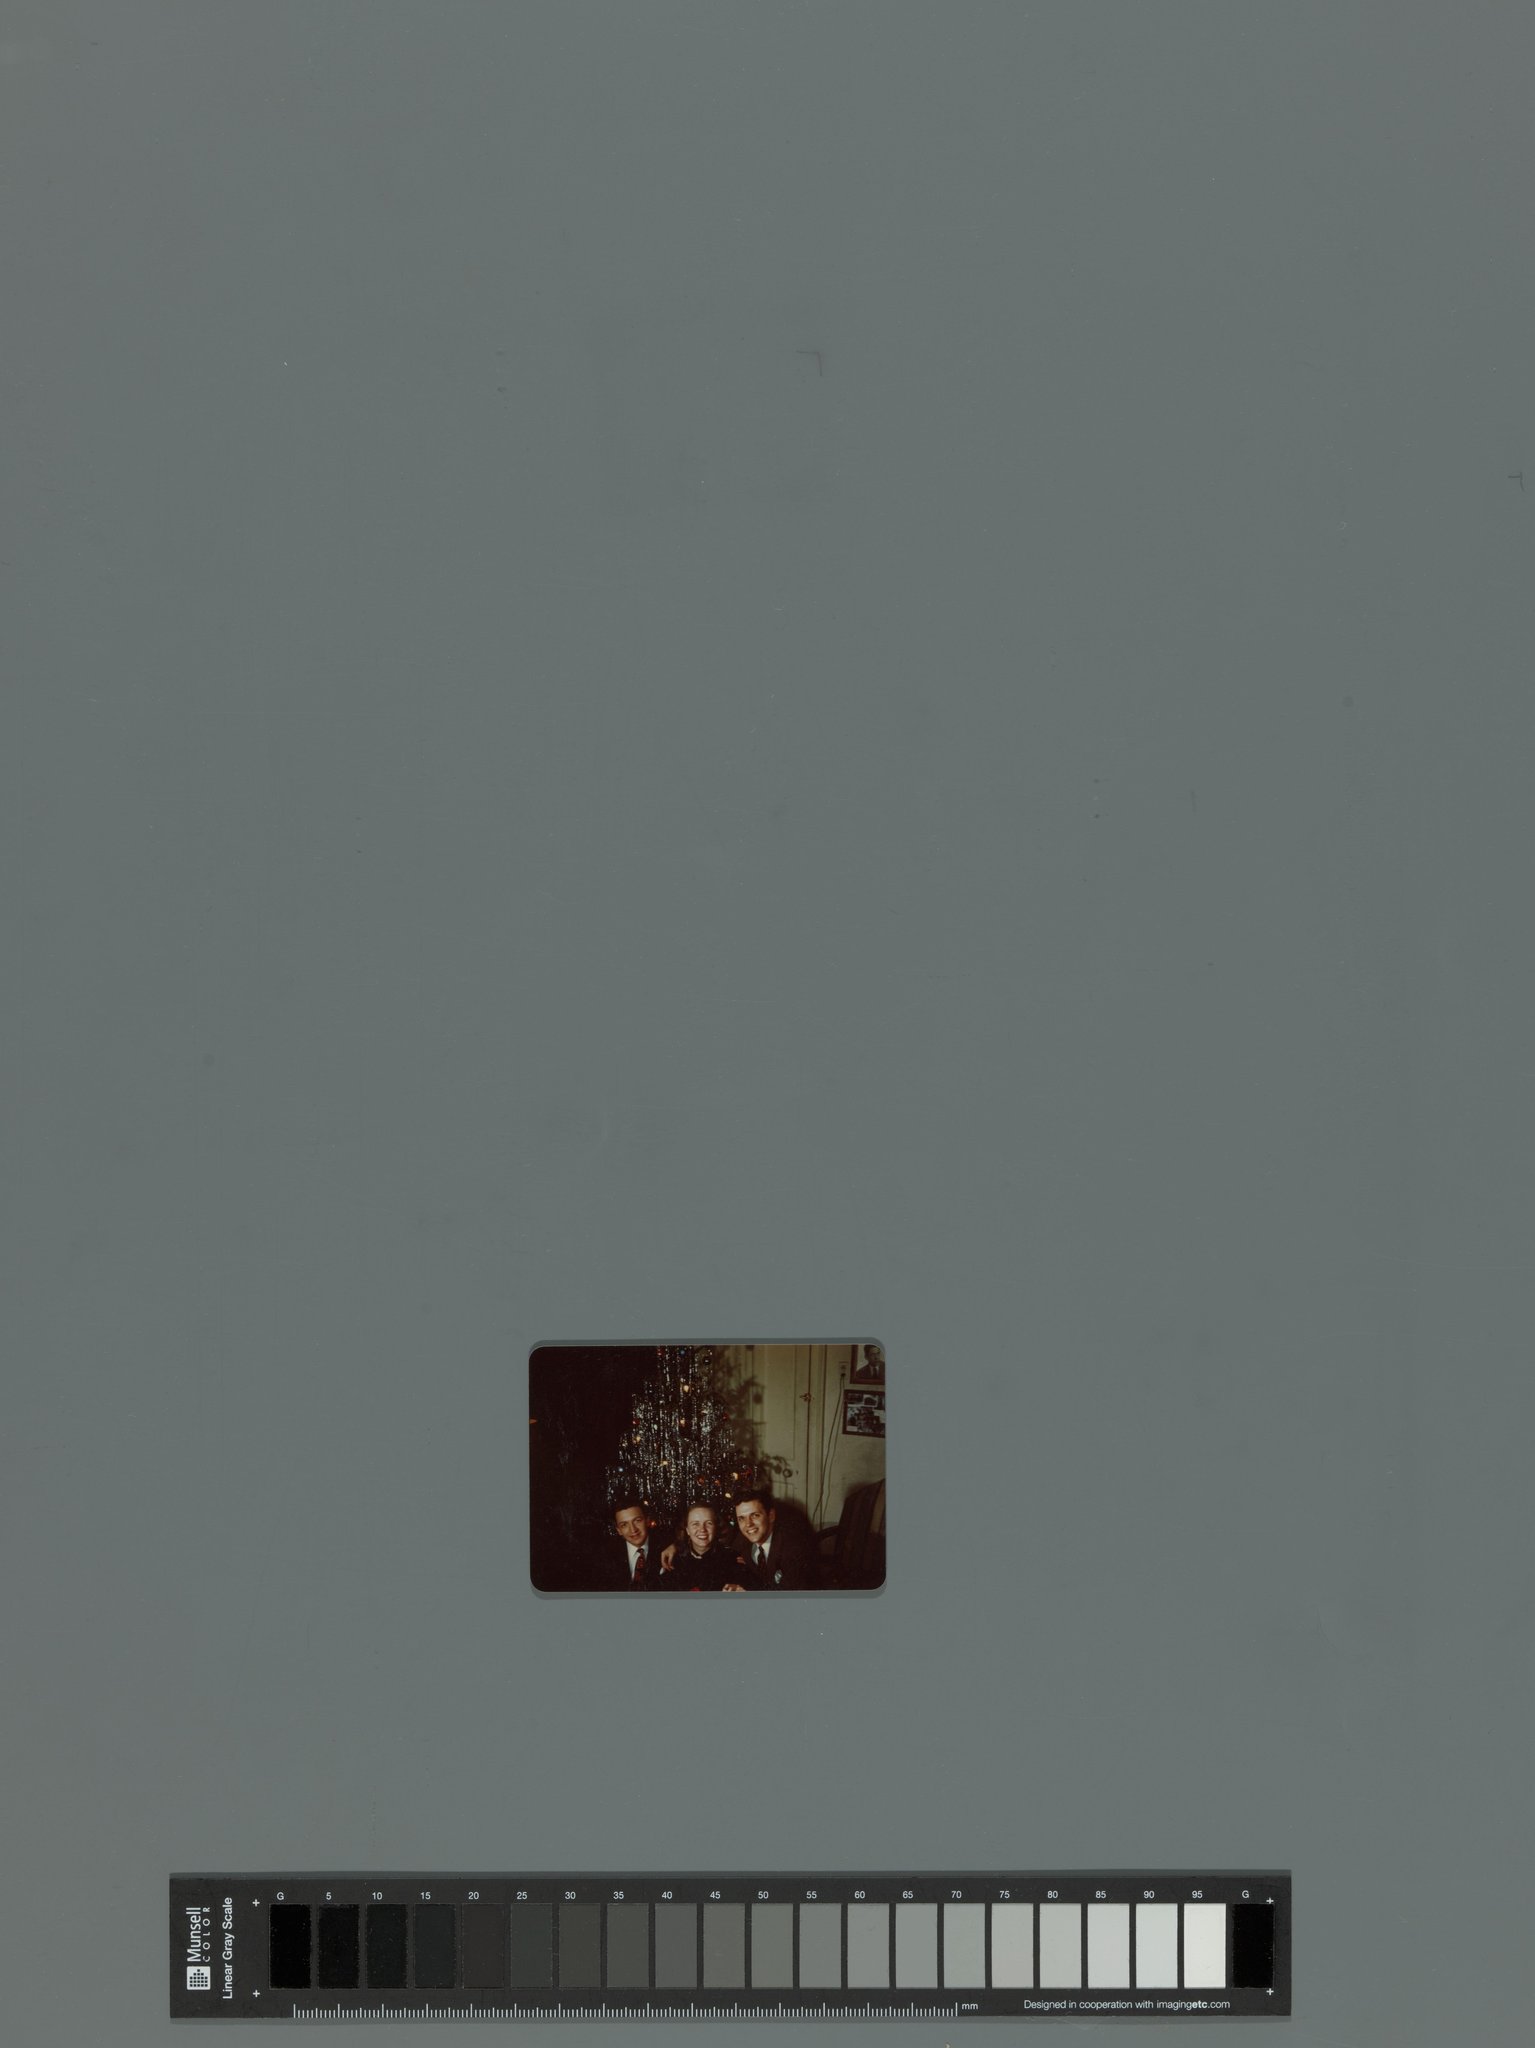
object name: photograph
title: Twee jonge mannen en jonge vrouw onder de kerstboom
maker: Anonymous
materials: photographic support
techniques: chromogenic print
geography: united states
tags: united states of america